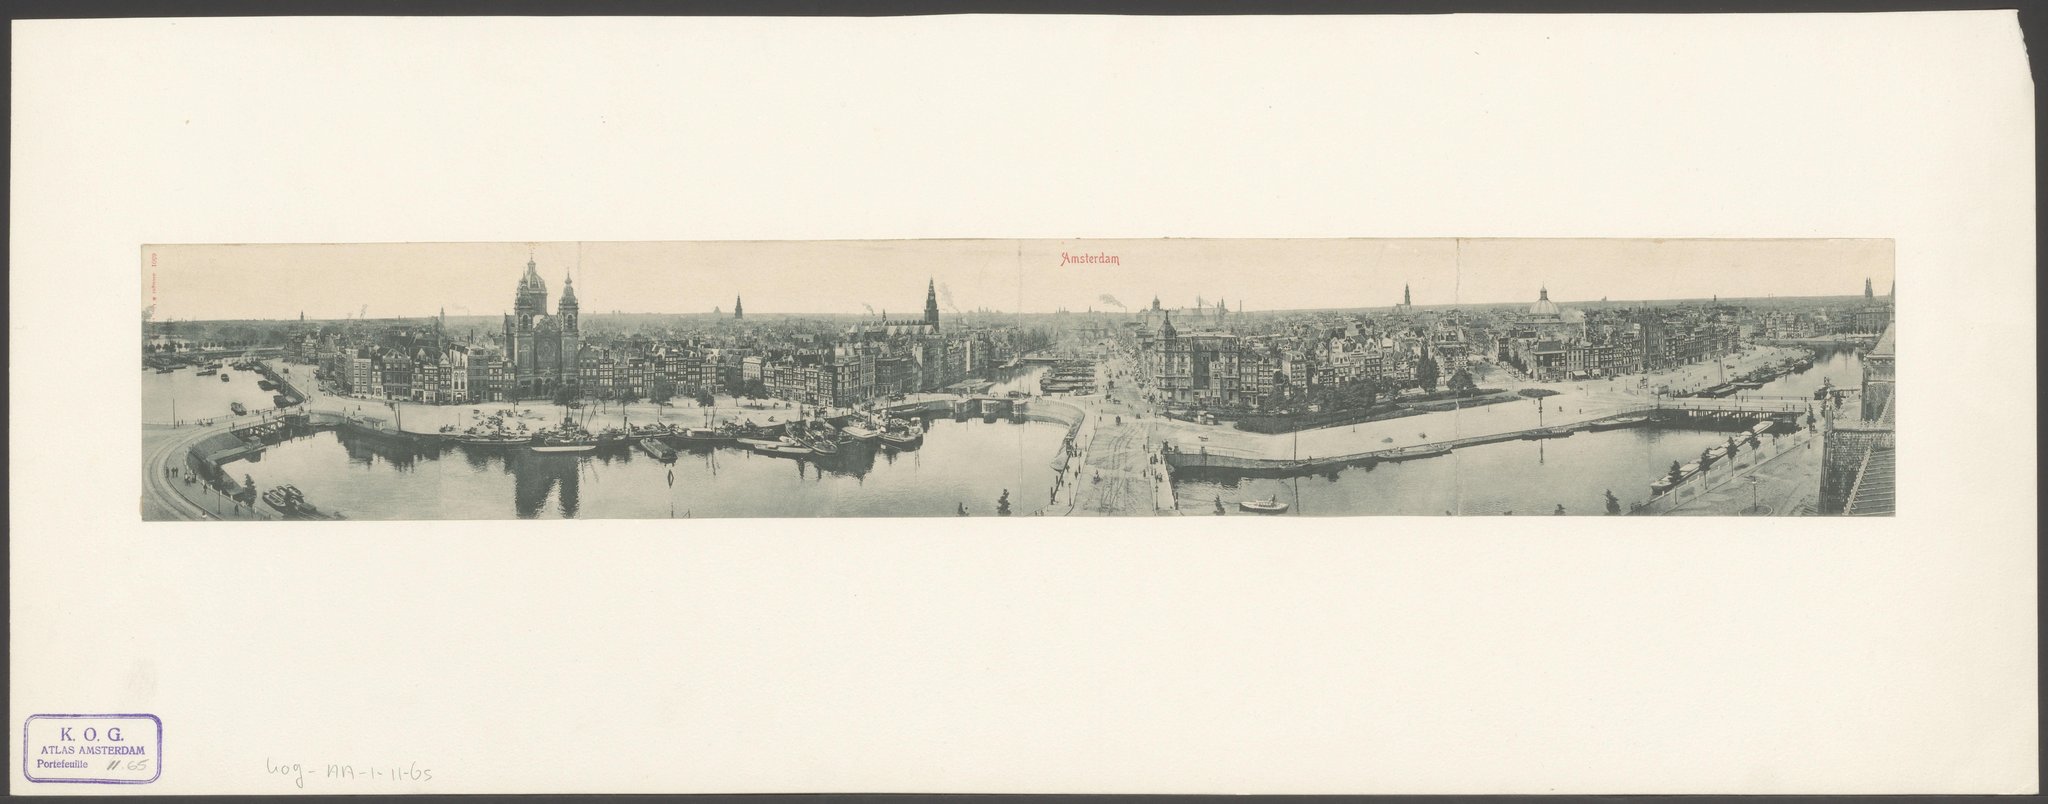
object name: photomechanical print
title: Panorama van de Prins Hendrikkade en het Damrak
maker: Anonymous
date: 1889-1926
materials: cardboard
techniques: photograph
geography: amsterdam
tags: city-view in general; 'veduta', river, church (exterior), bridge in city across river, canal, etc., street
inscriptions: collector's mark: ‘11.65’ Lugt 1641b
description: Onderwerpsrubriek binnen de Atlas Amsterdam: Prinsengracht, Korte Prinsengracht, Prins Hendrikkade. Zie ook Portefeuille 1: gezichten van het IJ op de stad.